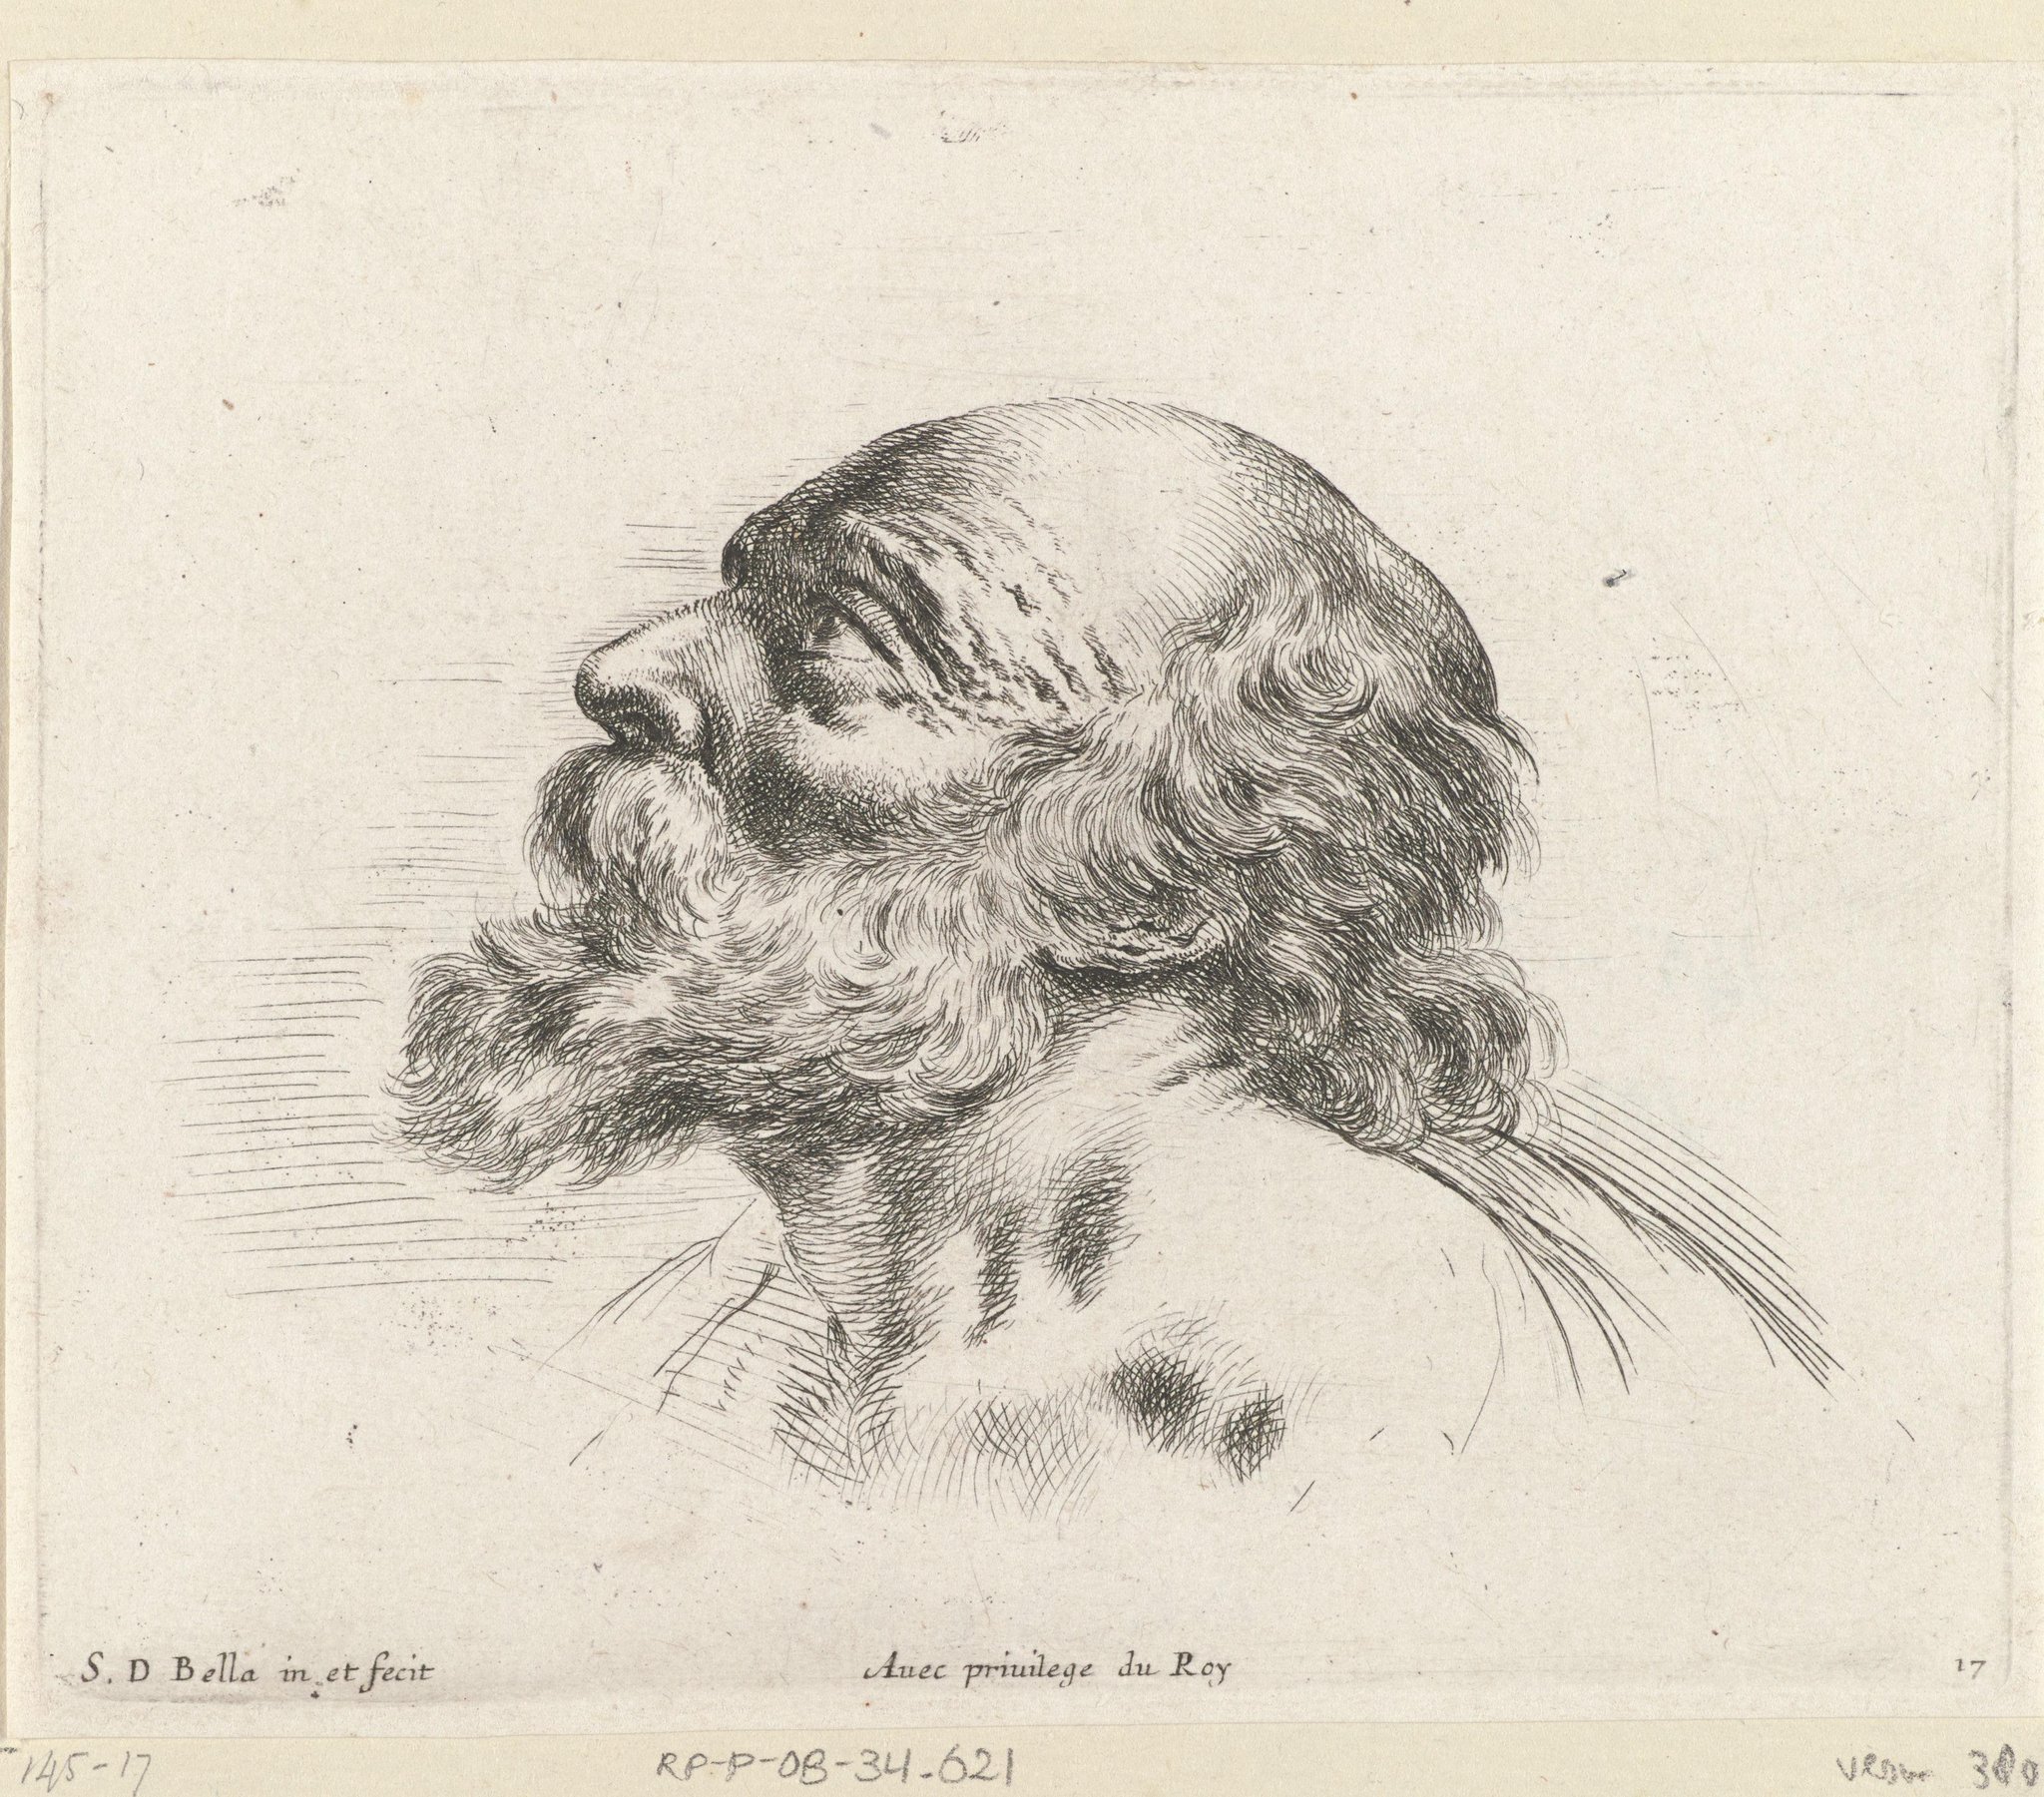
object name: print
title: I principii del disegno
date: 1620-1664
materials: paper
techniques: etching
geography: paris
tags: head (human) (+ sideview, profile), old man, the apostle peter, first bishop of rome; possible attributes: book, cock, (upturned) cross, (triple) crozier, fish, key, scroll, ship, tiara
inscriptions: collector's mark: Lugt 240